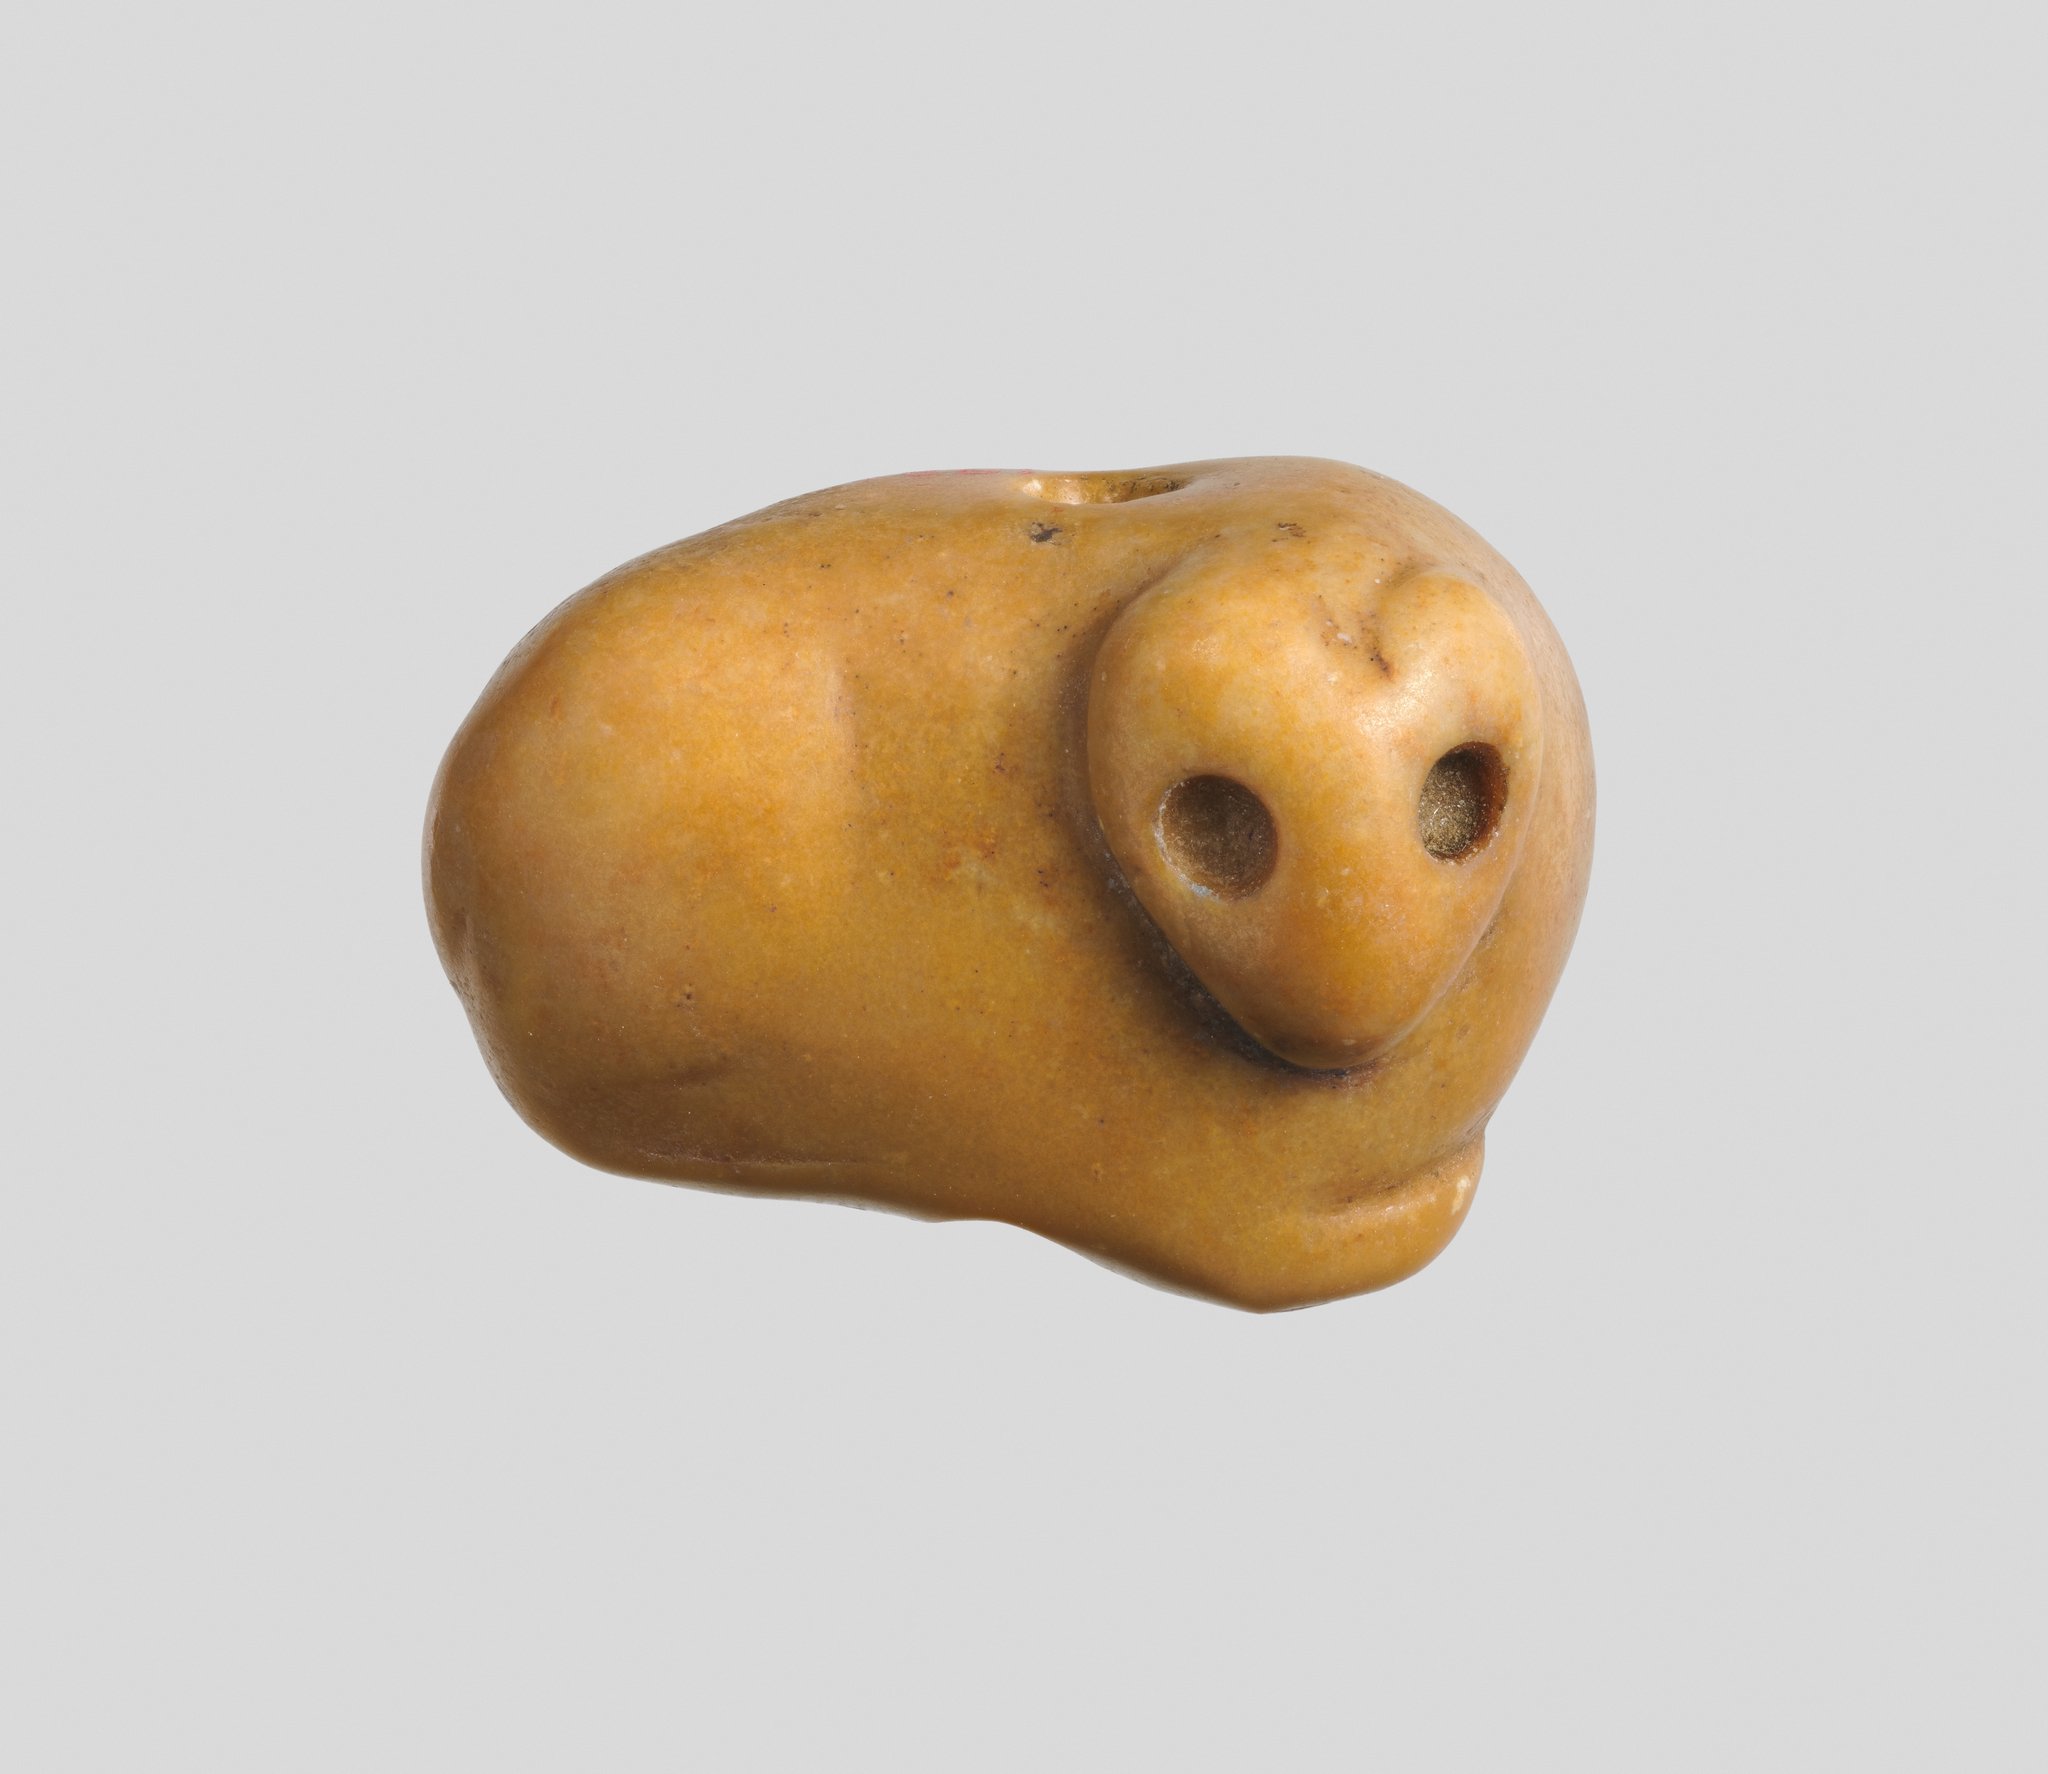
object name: stamp seal amulet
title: Seal amulet in the form of a recumbent fox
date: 3500-2900 BCE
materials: marble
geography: mesopotamia or southwestern iran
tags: foxes